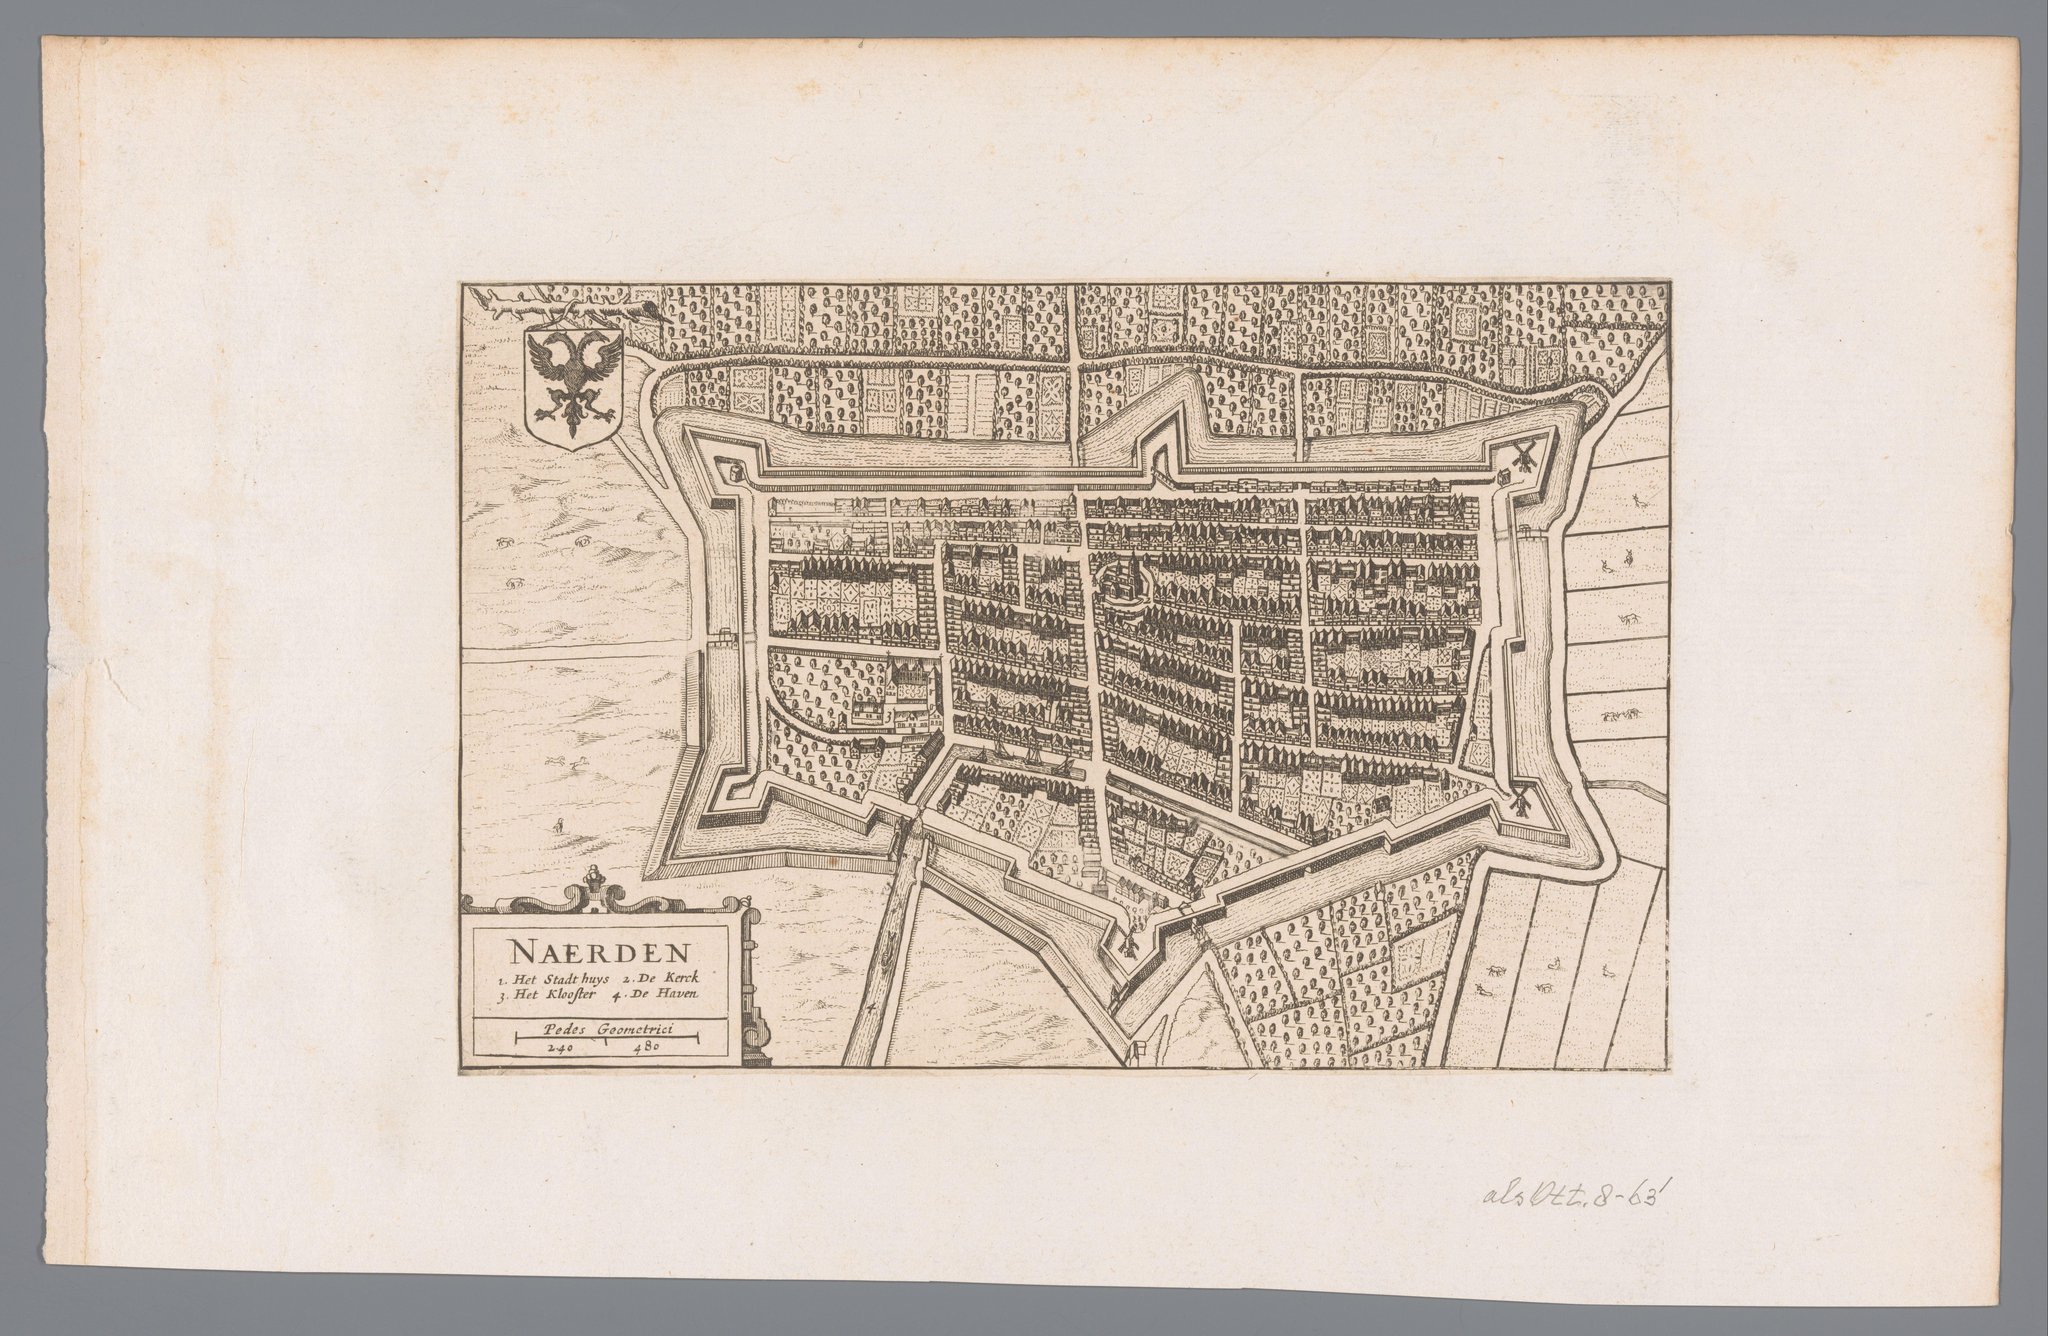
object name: area plan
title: Plattegrond van Naarden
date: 1649-1652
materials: paper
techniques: etching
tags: maps, atlases